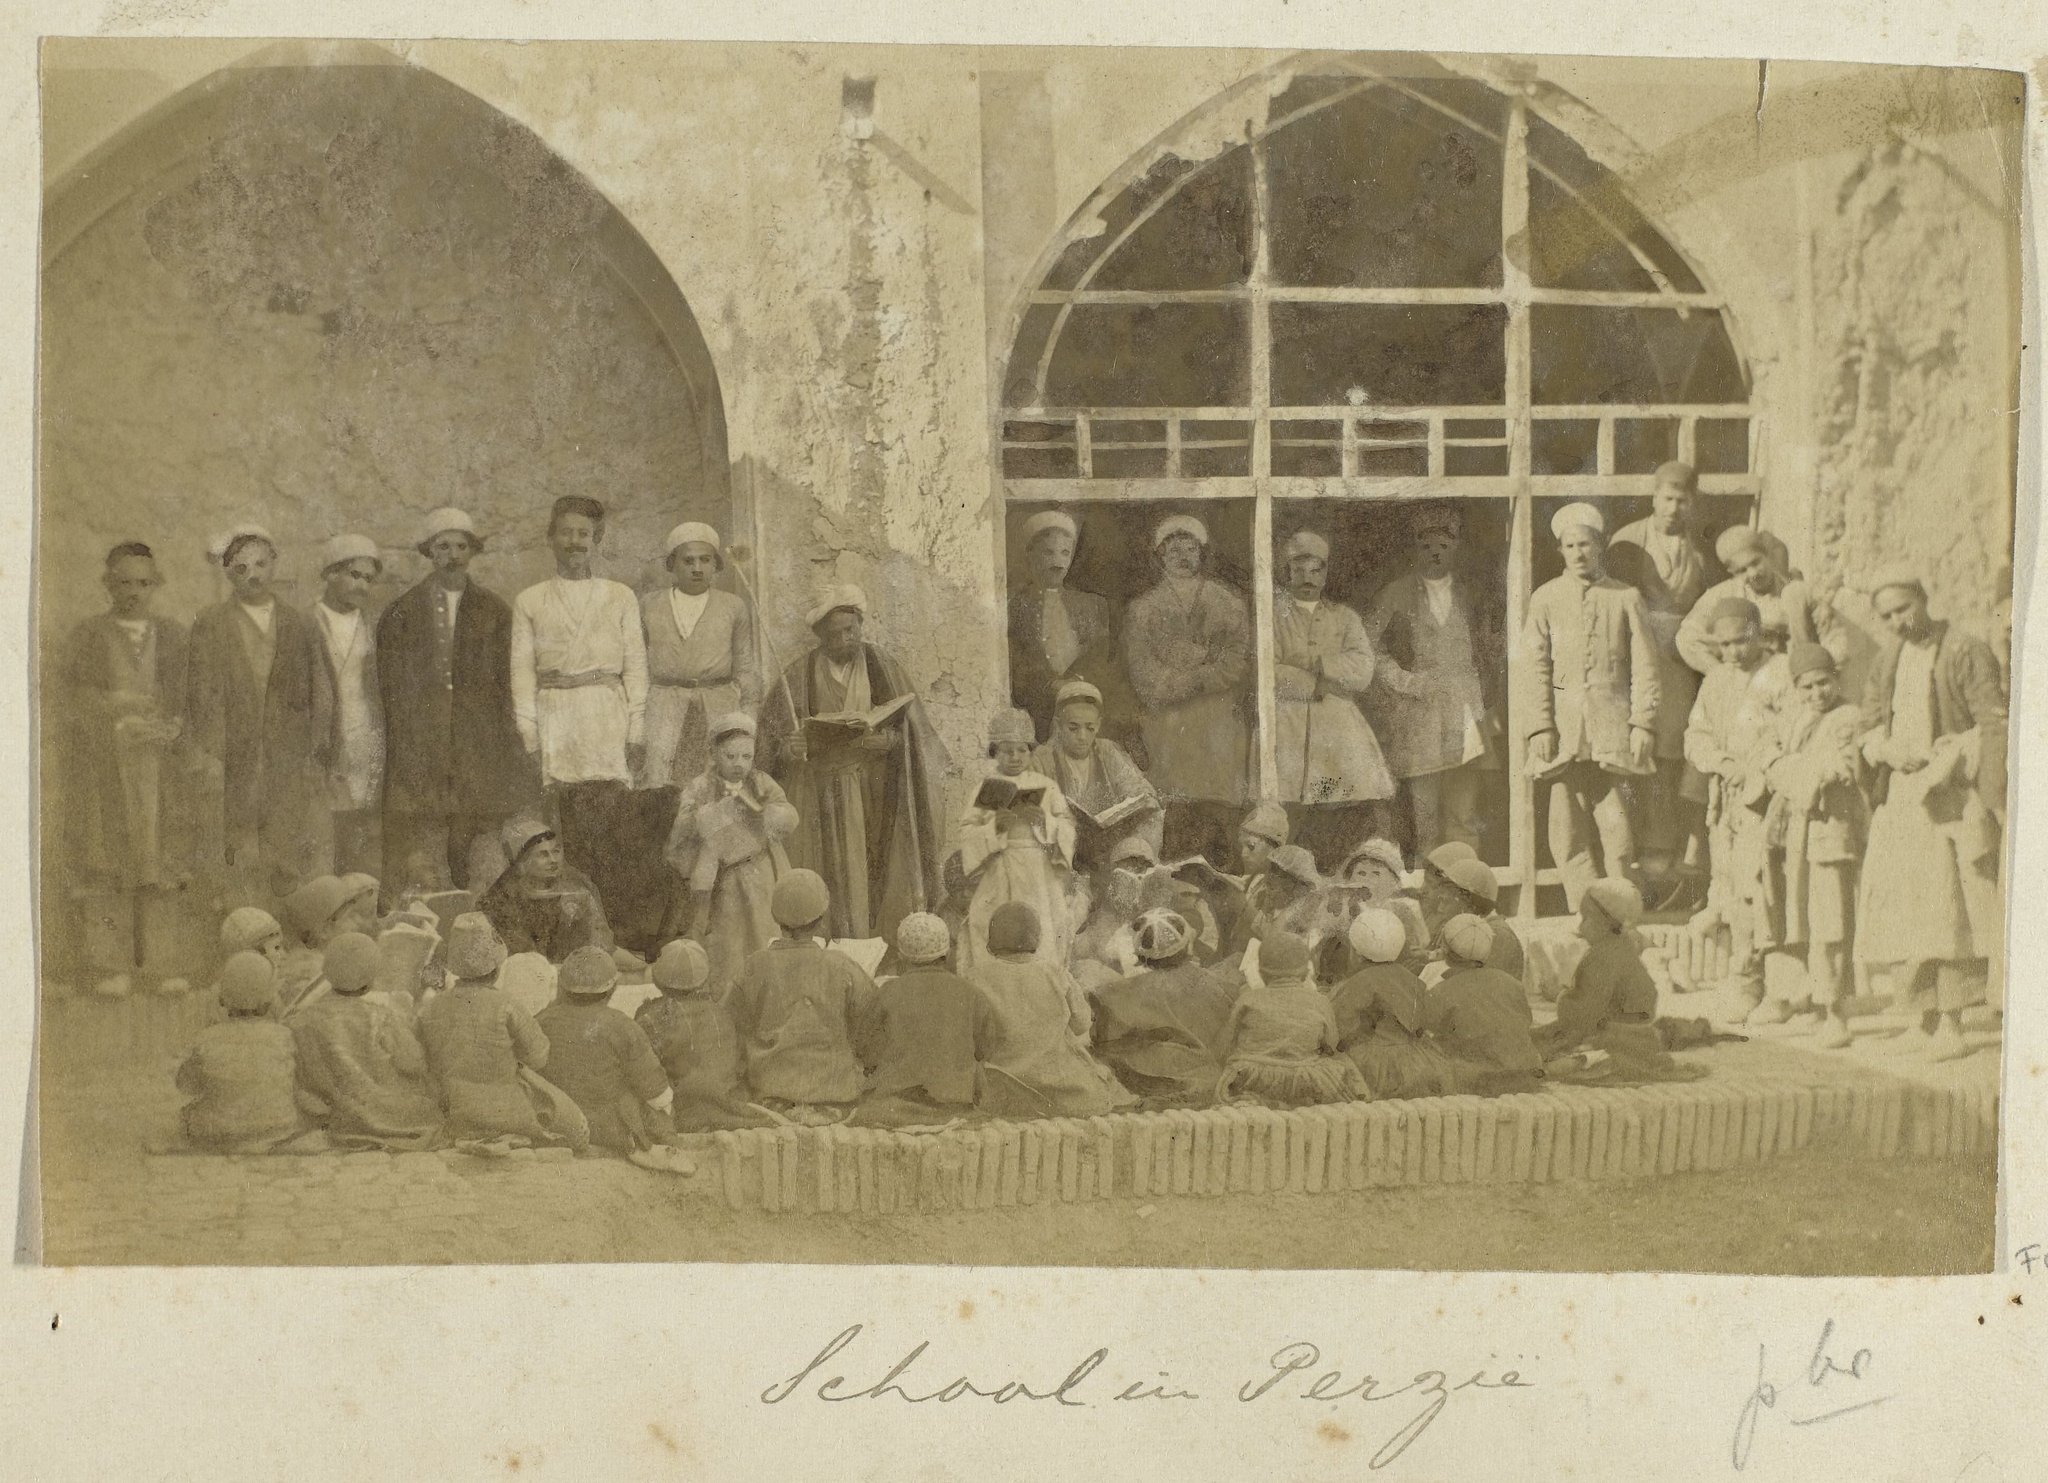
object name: photograph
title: School in Perzië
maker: antoine sevruguin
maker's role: fotograaf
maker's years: 1840-1933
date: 1880-1895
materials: paper, photographic support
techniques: albumen print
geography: iran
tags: reading, elementary school; class, form, persia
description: Onderdeel van Reisalbum van H. Dunlop met foto's van bezienswaardigheden in Perzië, Schotland, Duitsland, Rusland, China en Canada.